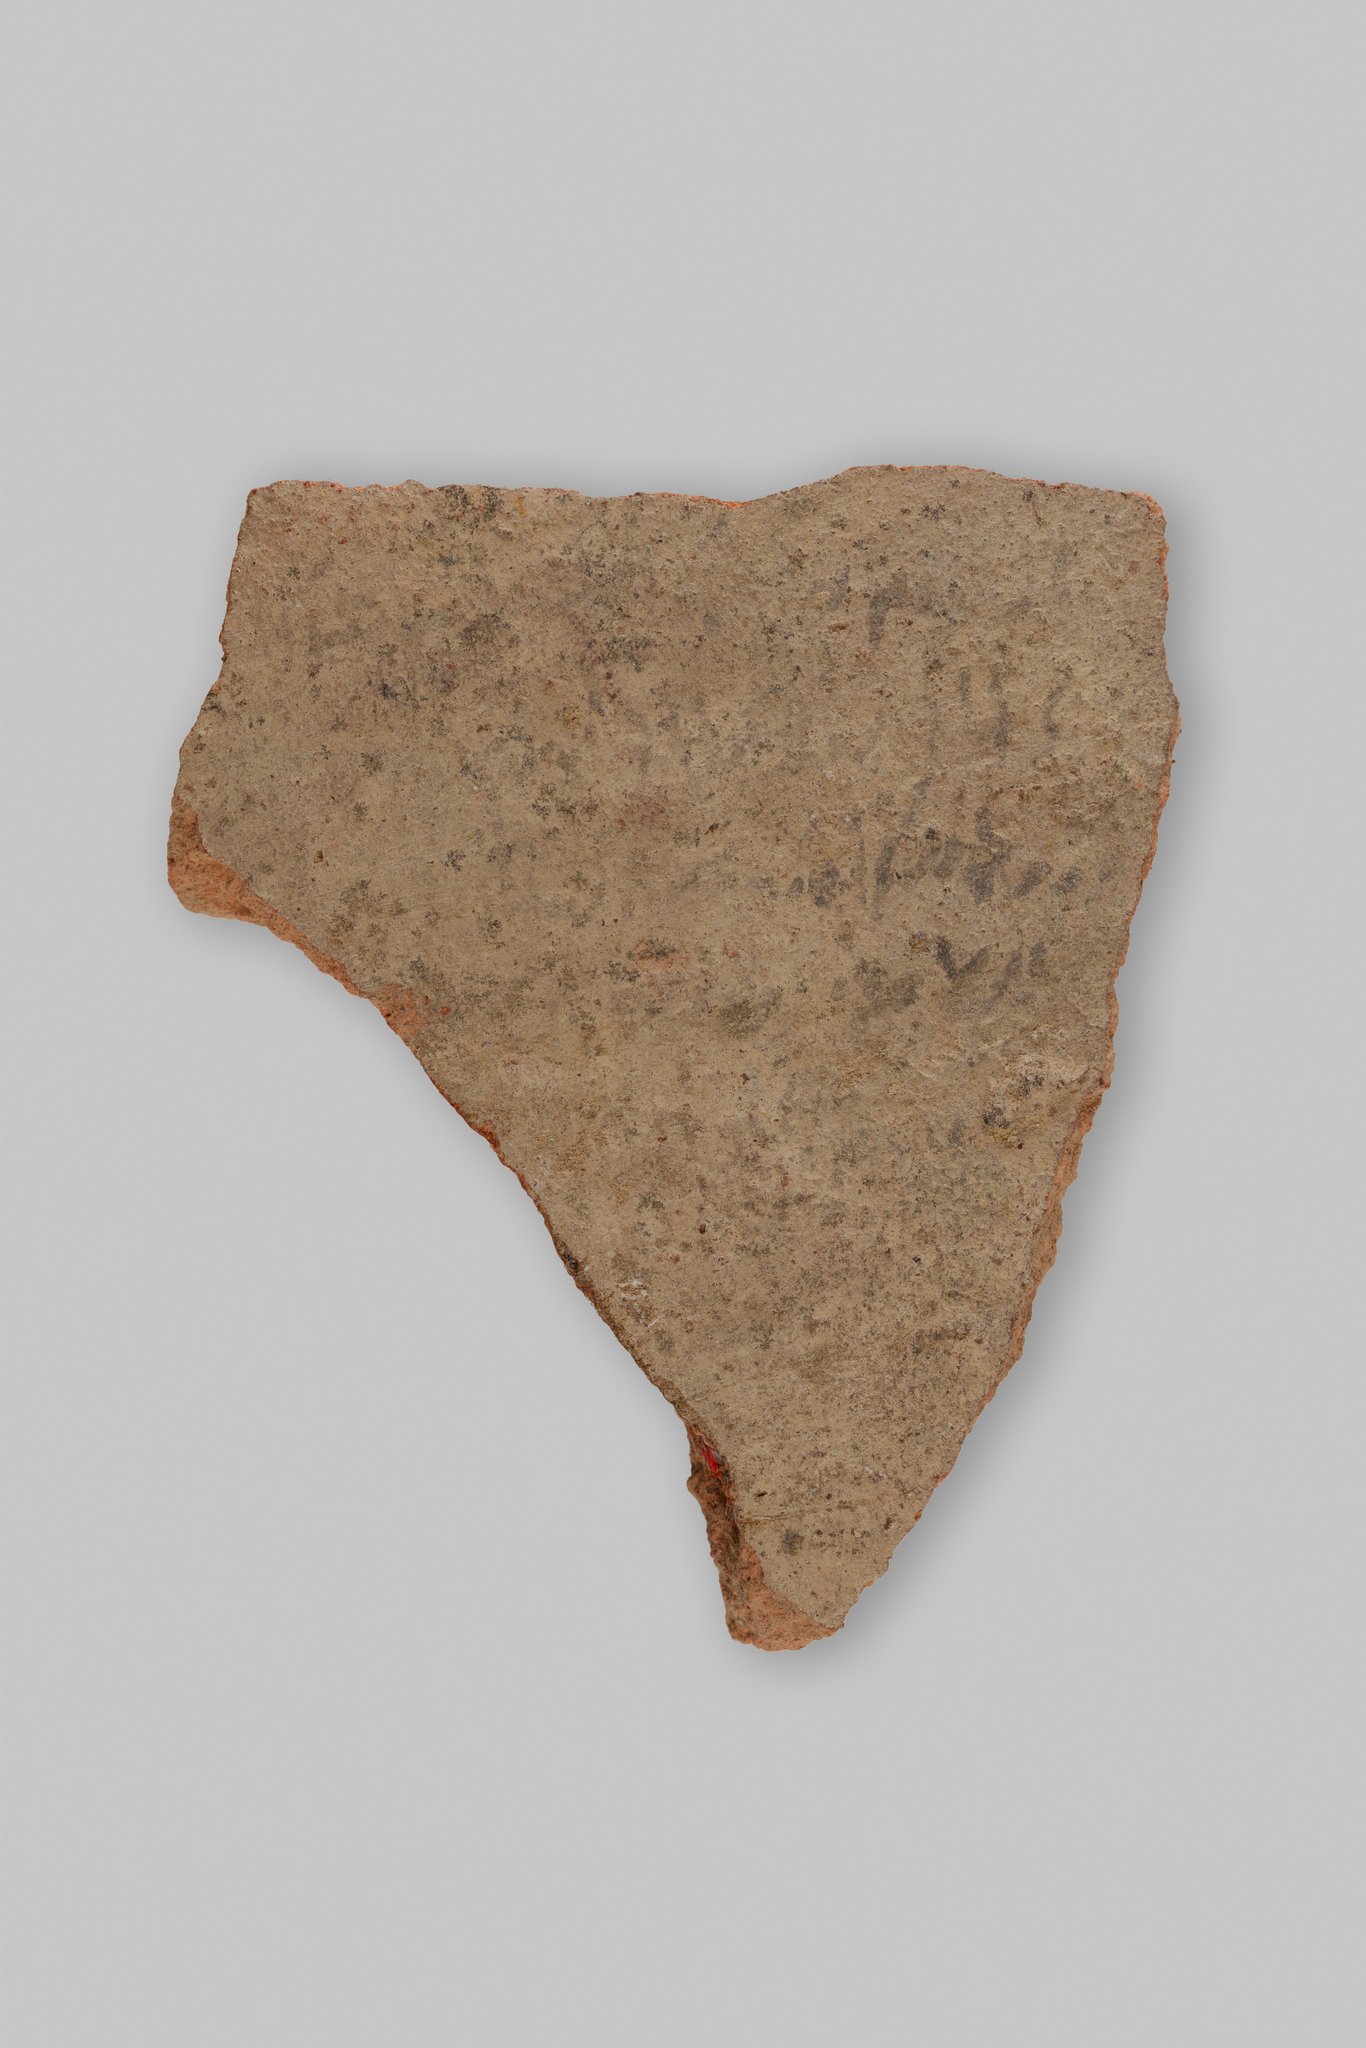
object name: ostracon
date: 400-30 BCE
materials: ink, pottery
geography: egypt